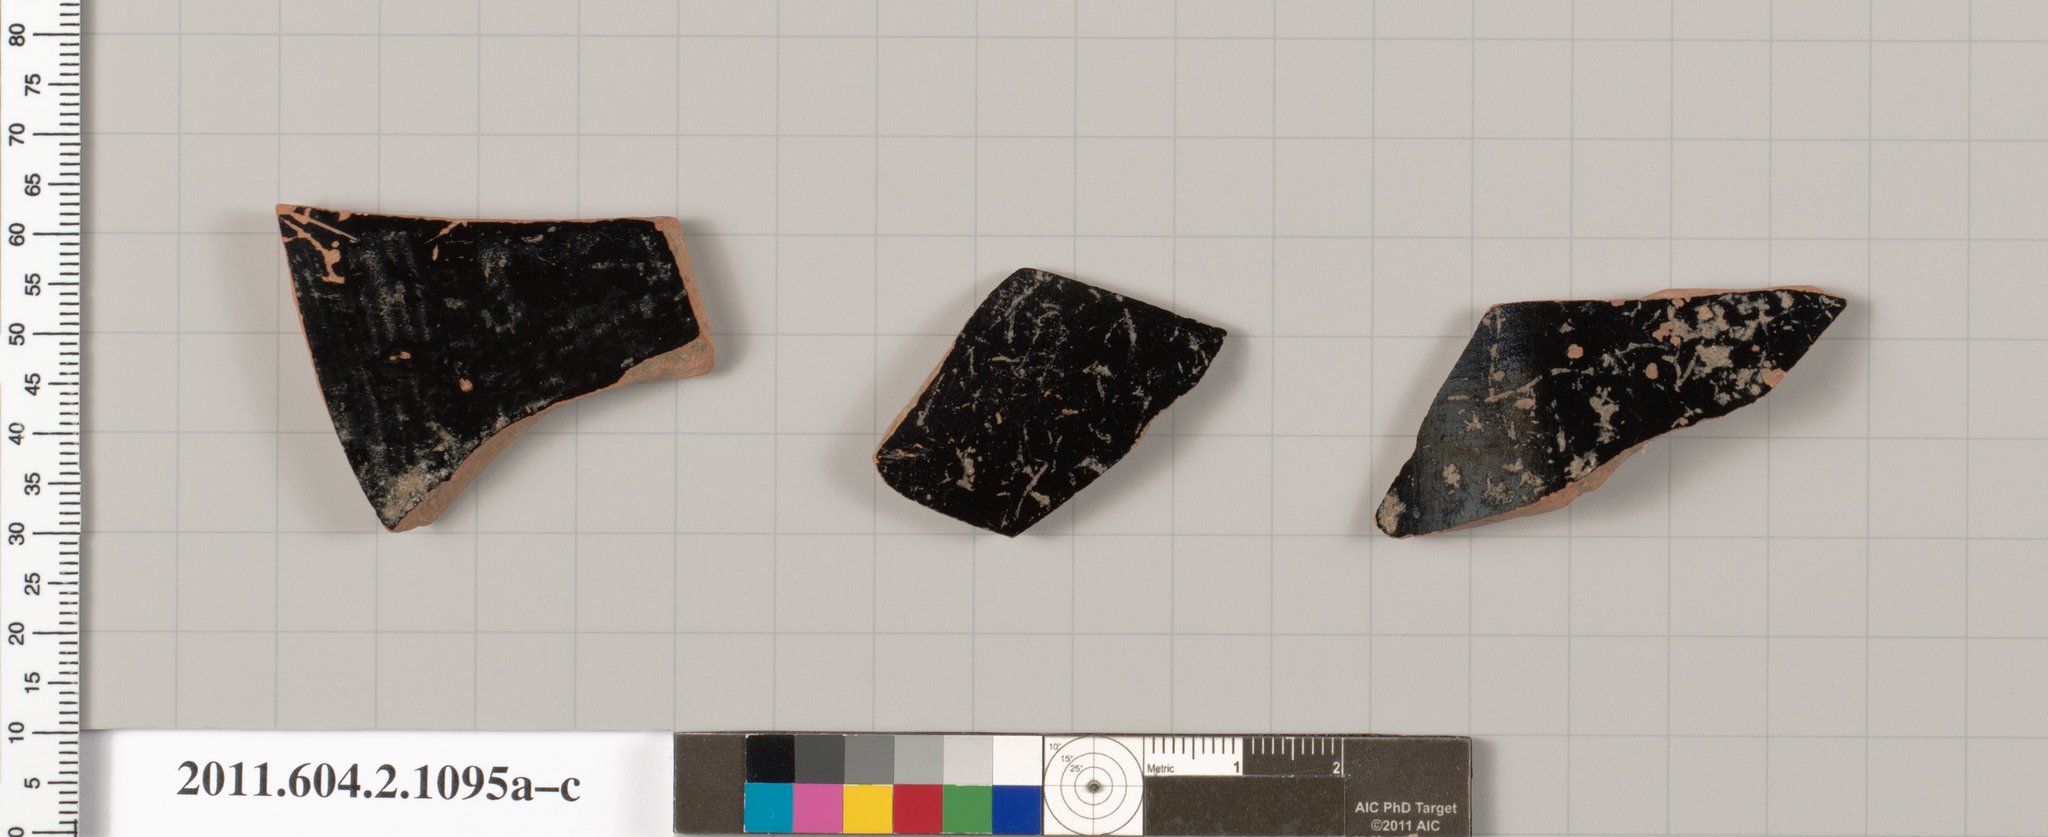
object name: lekythos fragment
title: Terracotta fragments of lekythoi (oil flasks)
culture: greek, attic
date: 500-451 BCE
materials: terracotta